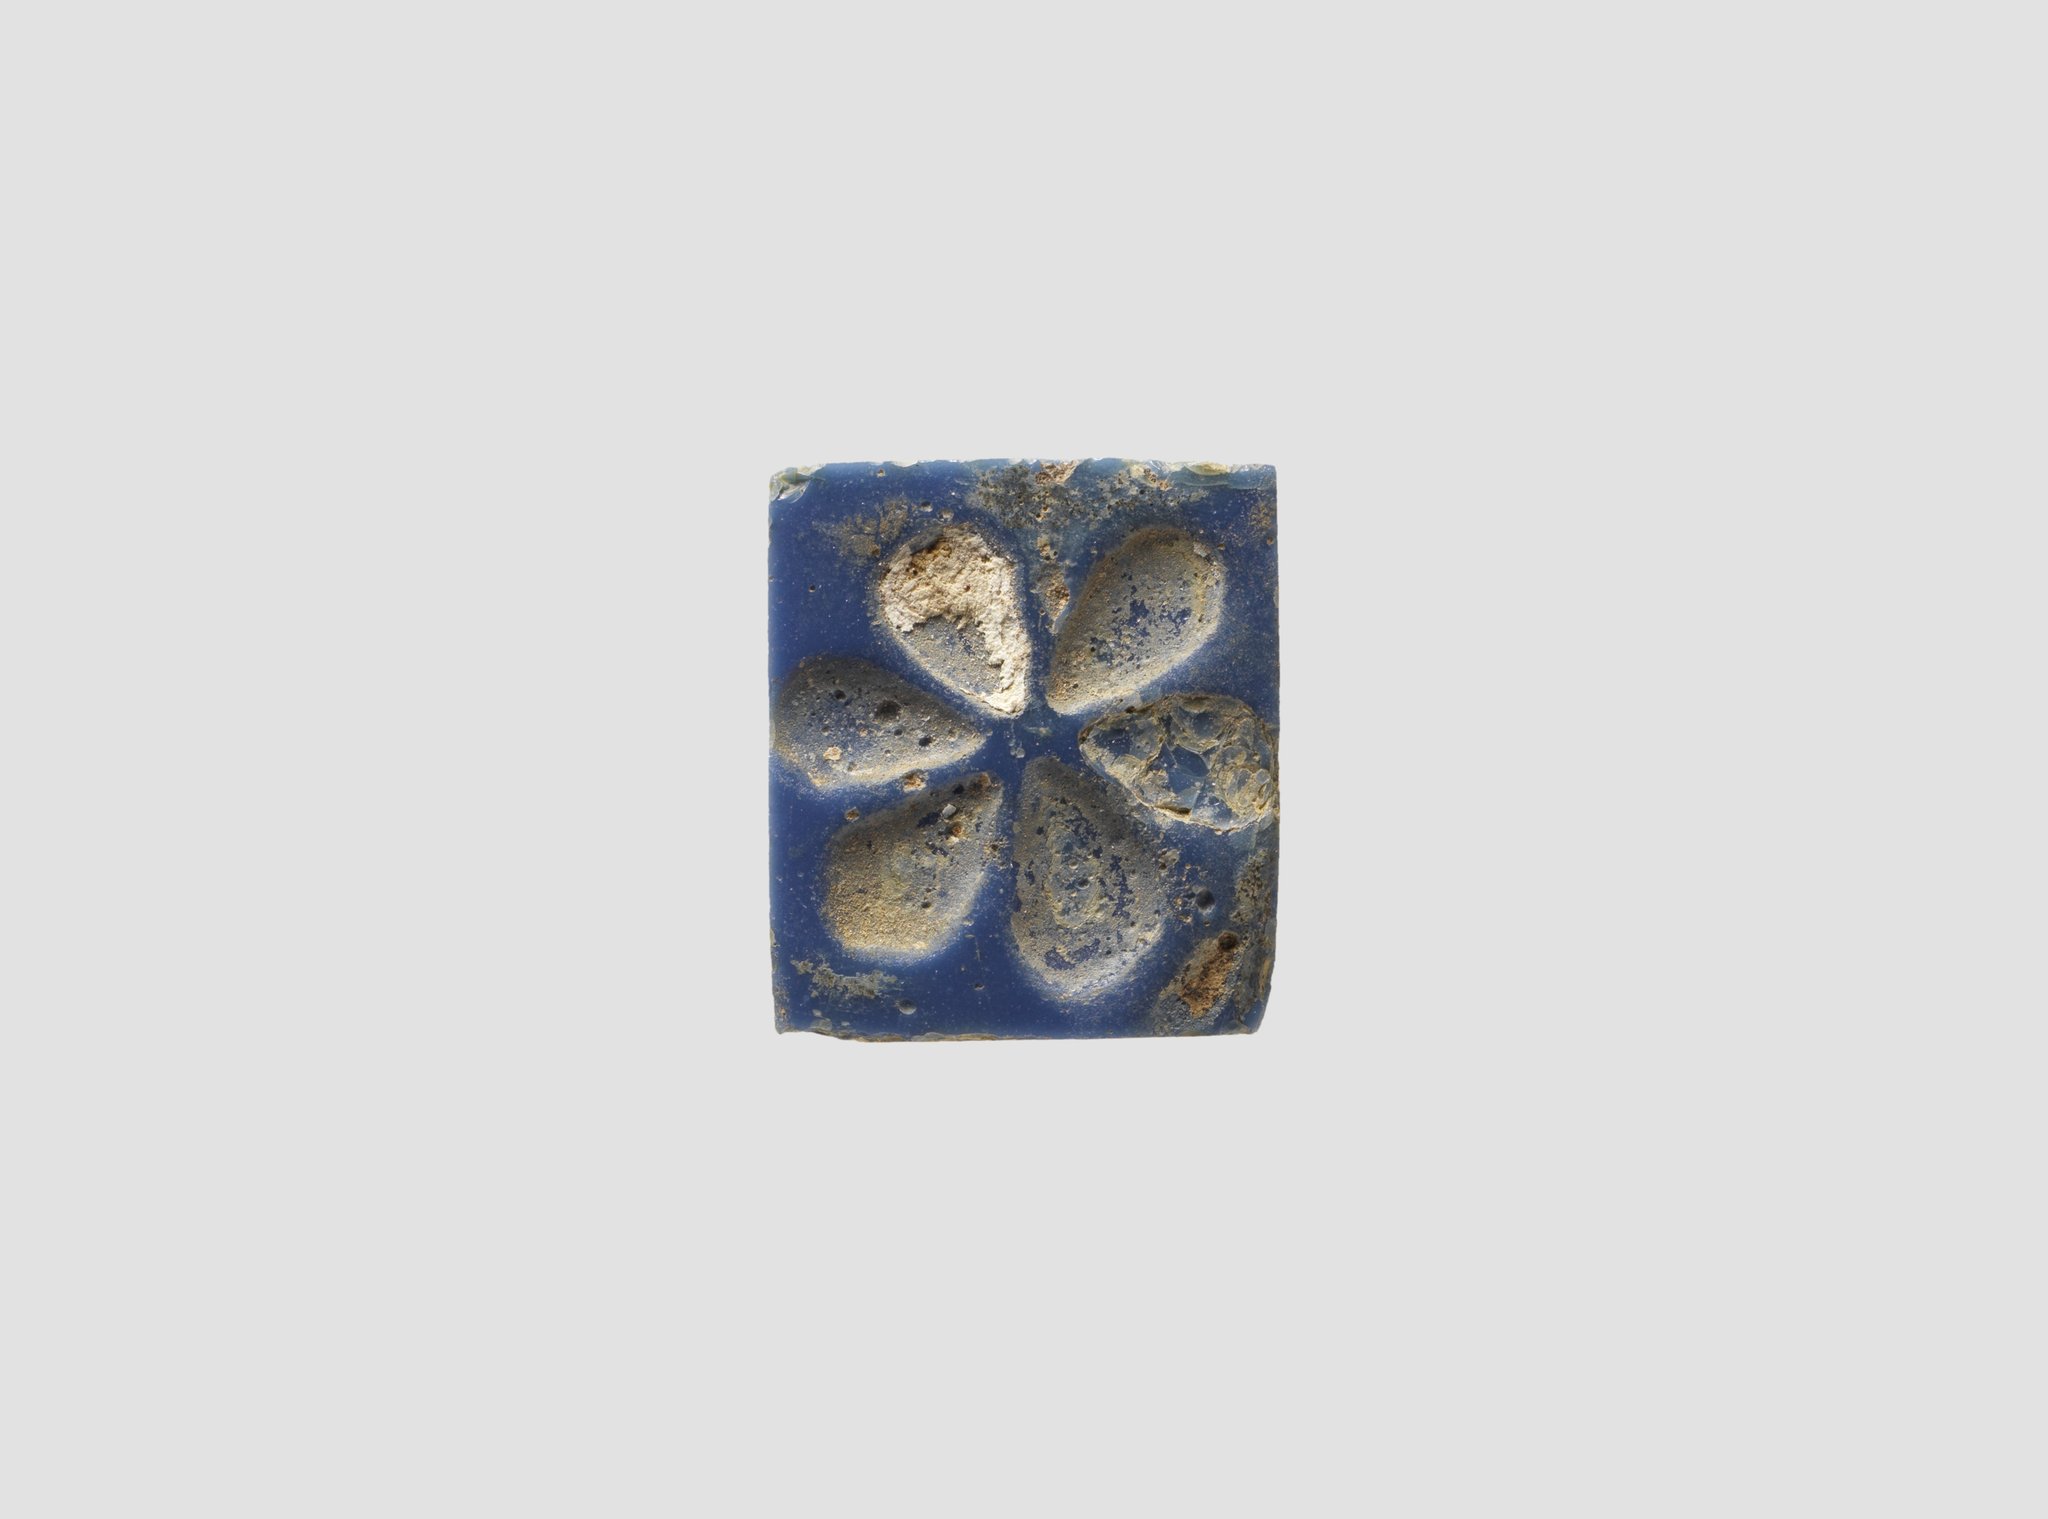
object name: inlay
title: Square inlay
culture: assyrian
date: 900-601 BCE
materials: glass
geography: mesopotamia